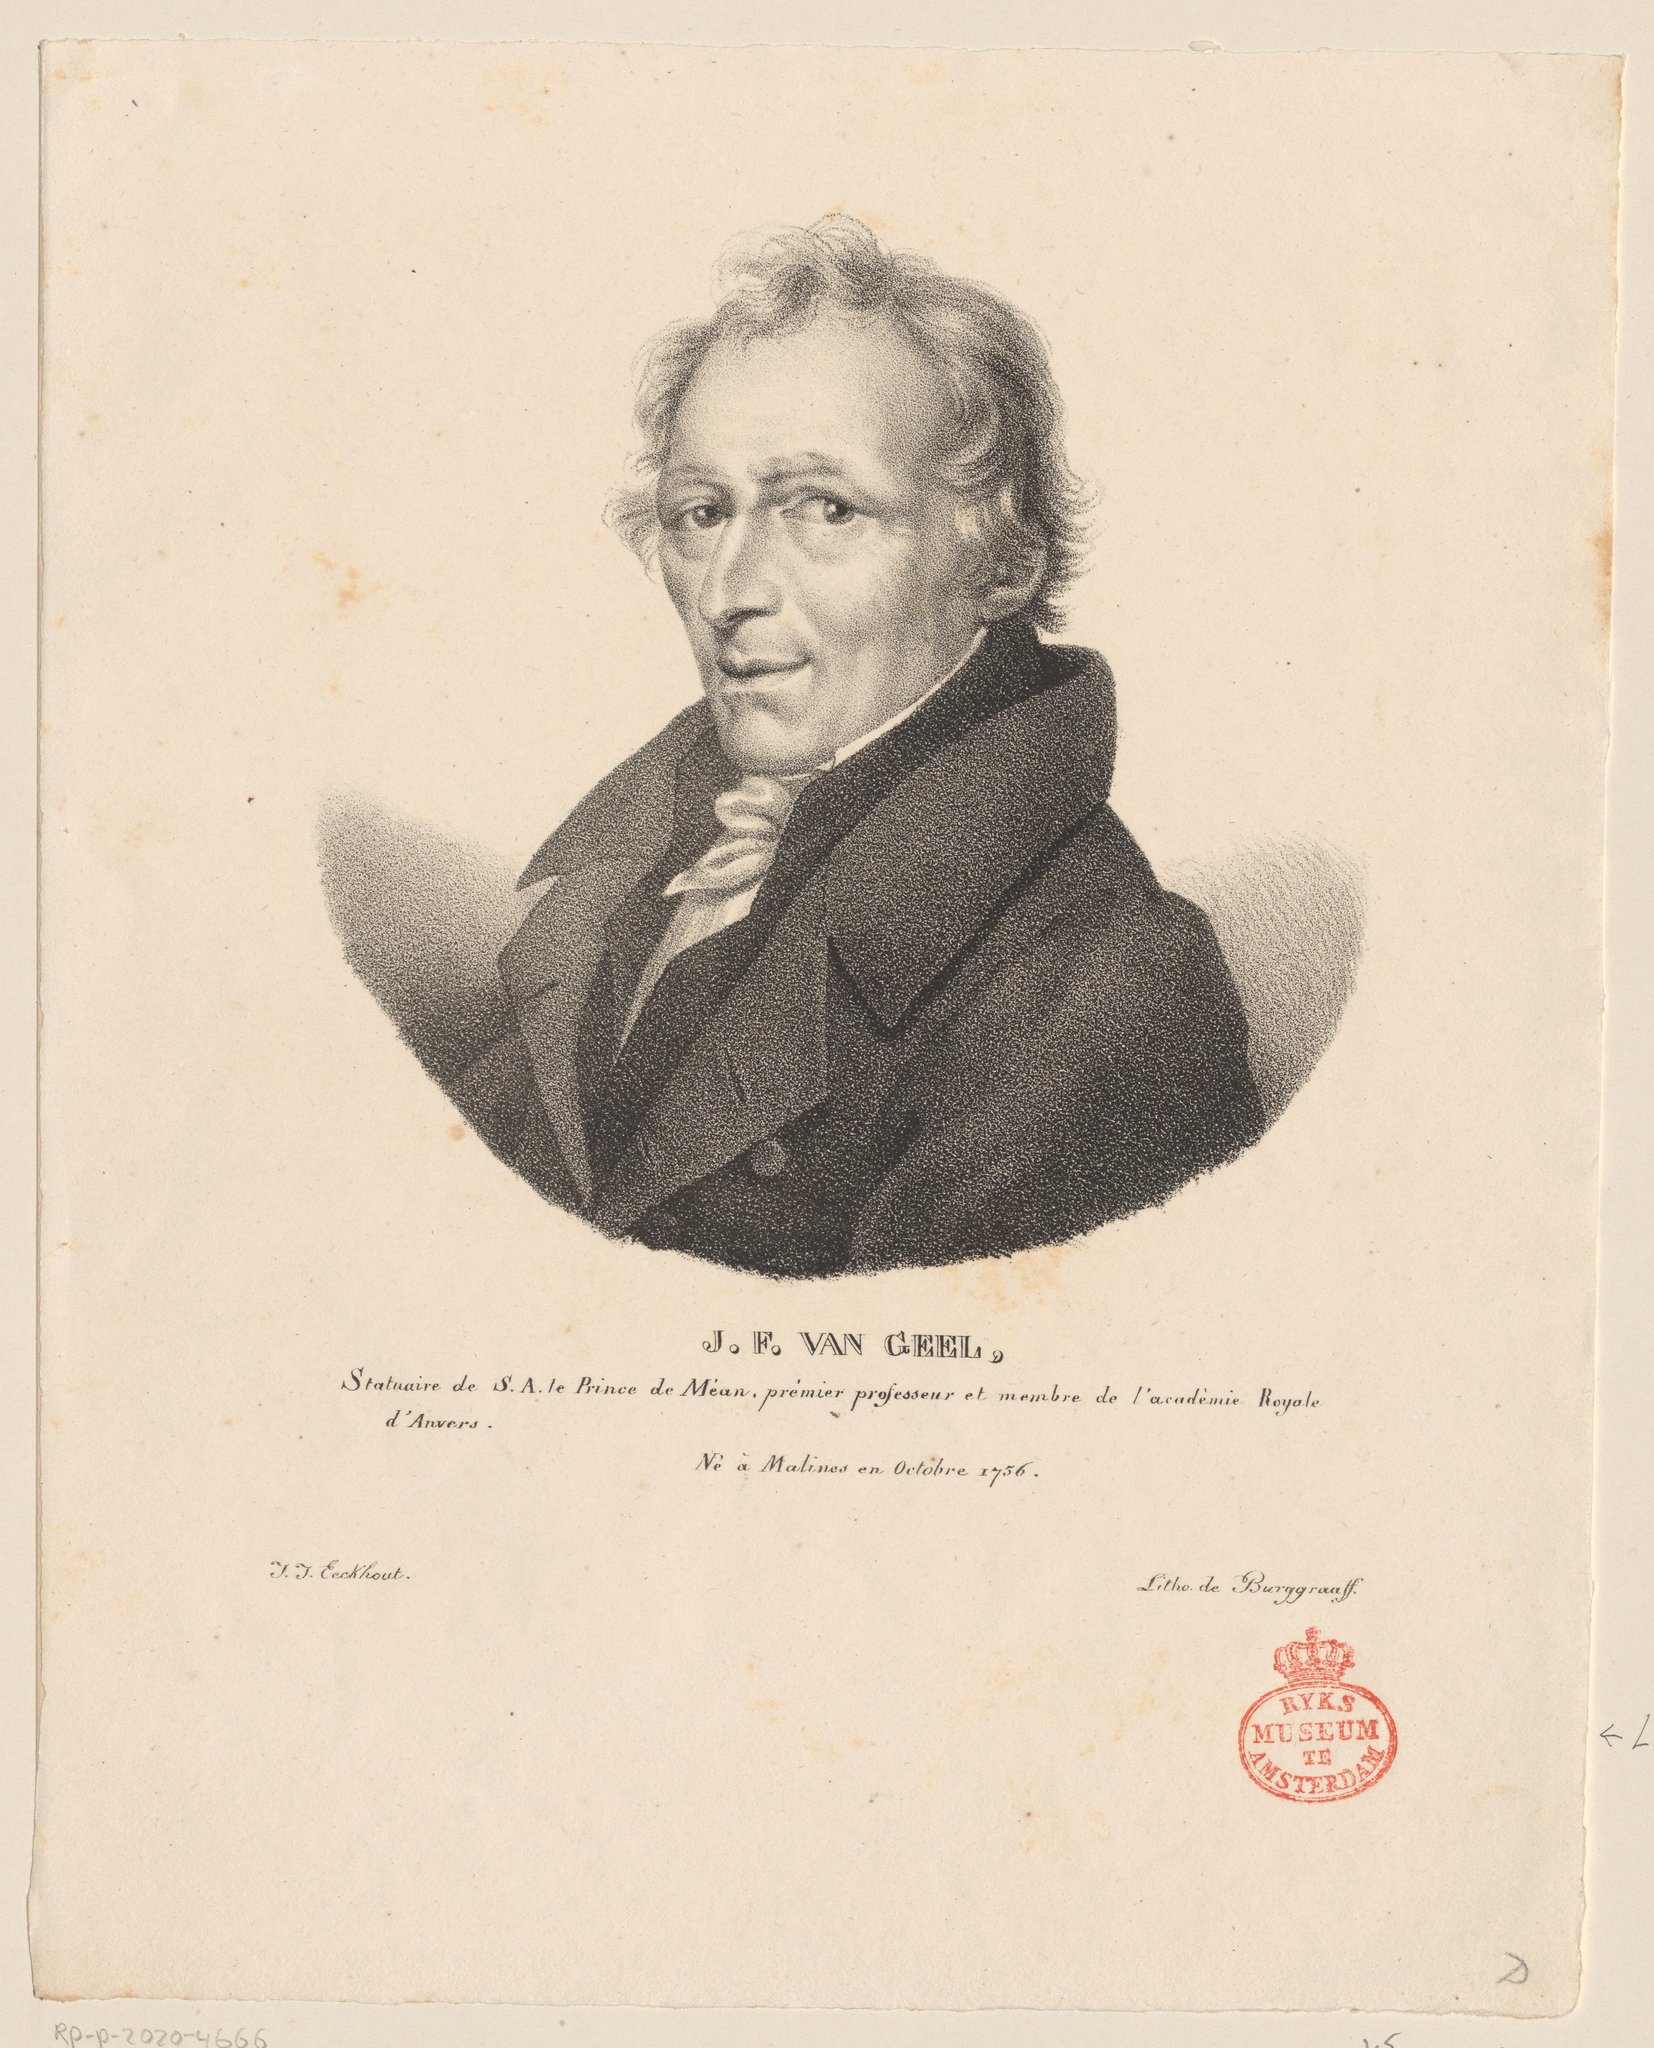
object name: print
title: Portraits des artistes modernes nés dans le Royaume des Pays-Bas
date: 1822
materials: paper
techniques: lithograph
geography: brussels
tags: mechelen, antwerp, sculptor, jan frans van geel, portrait, self-portrait of sculptor, historical persons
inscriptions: collector's mark: Lugt 12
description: Prent maakt deel uit van een serie van zestig prenten.